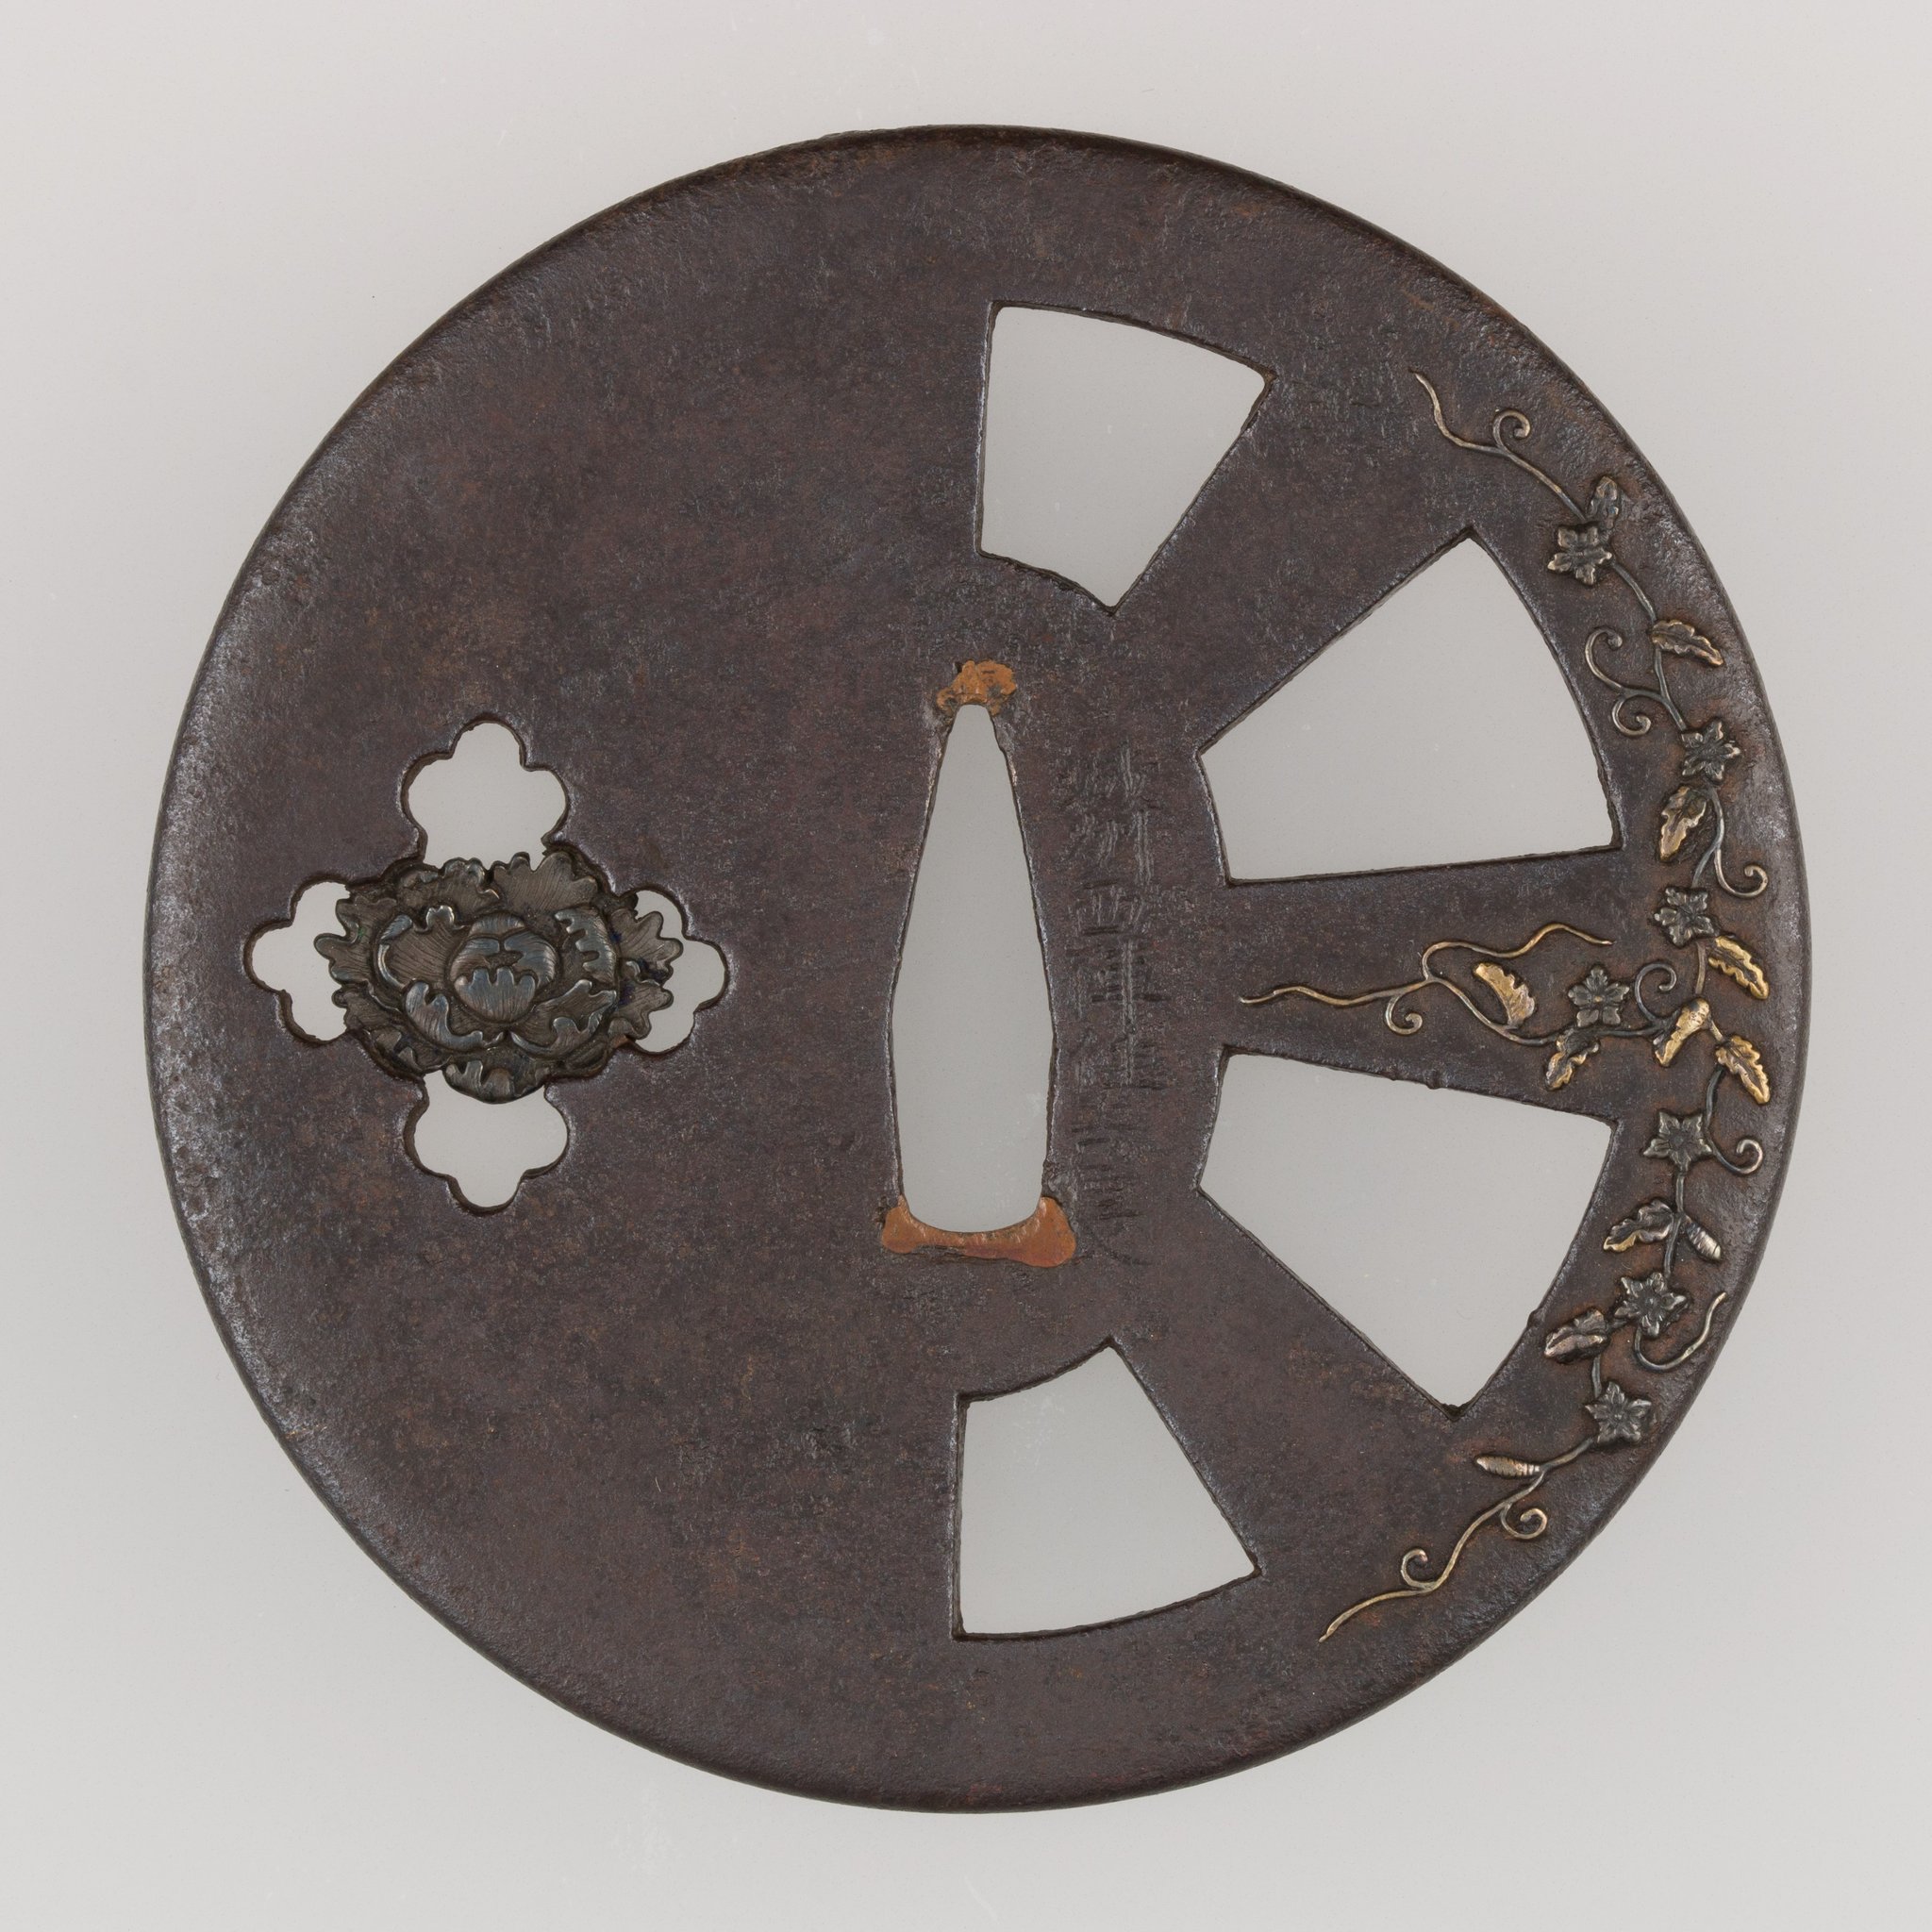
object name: sword guard tsuba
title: Sword Guard (Tsuba)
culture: japanese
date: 1601-1633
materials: bronze, copper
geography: japan